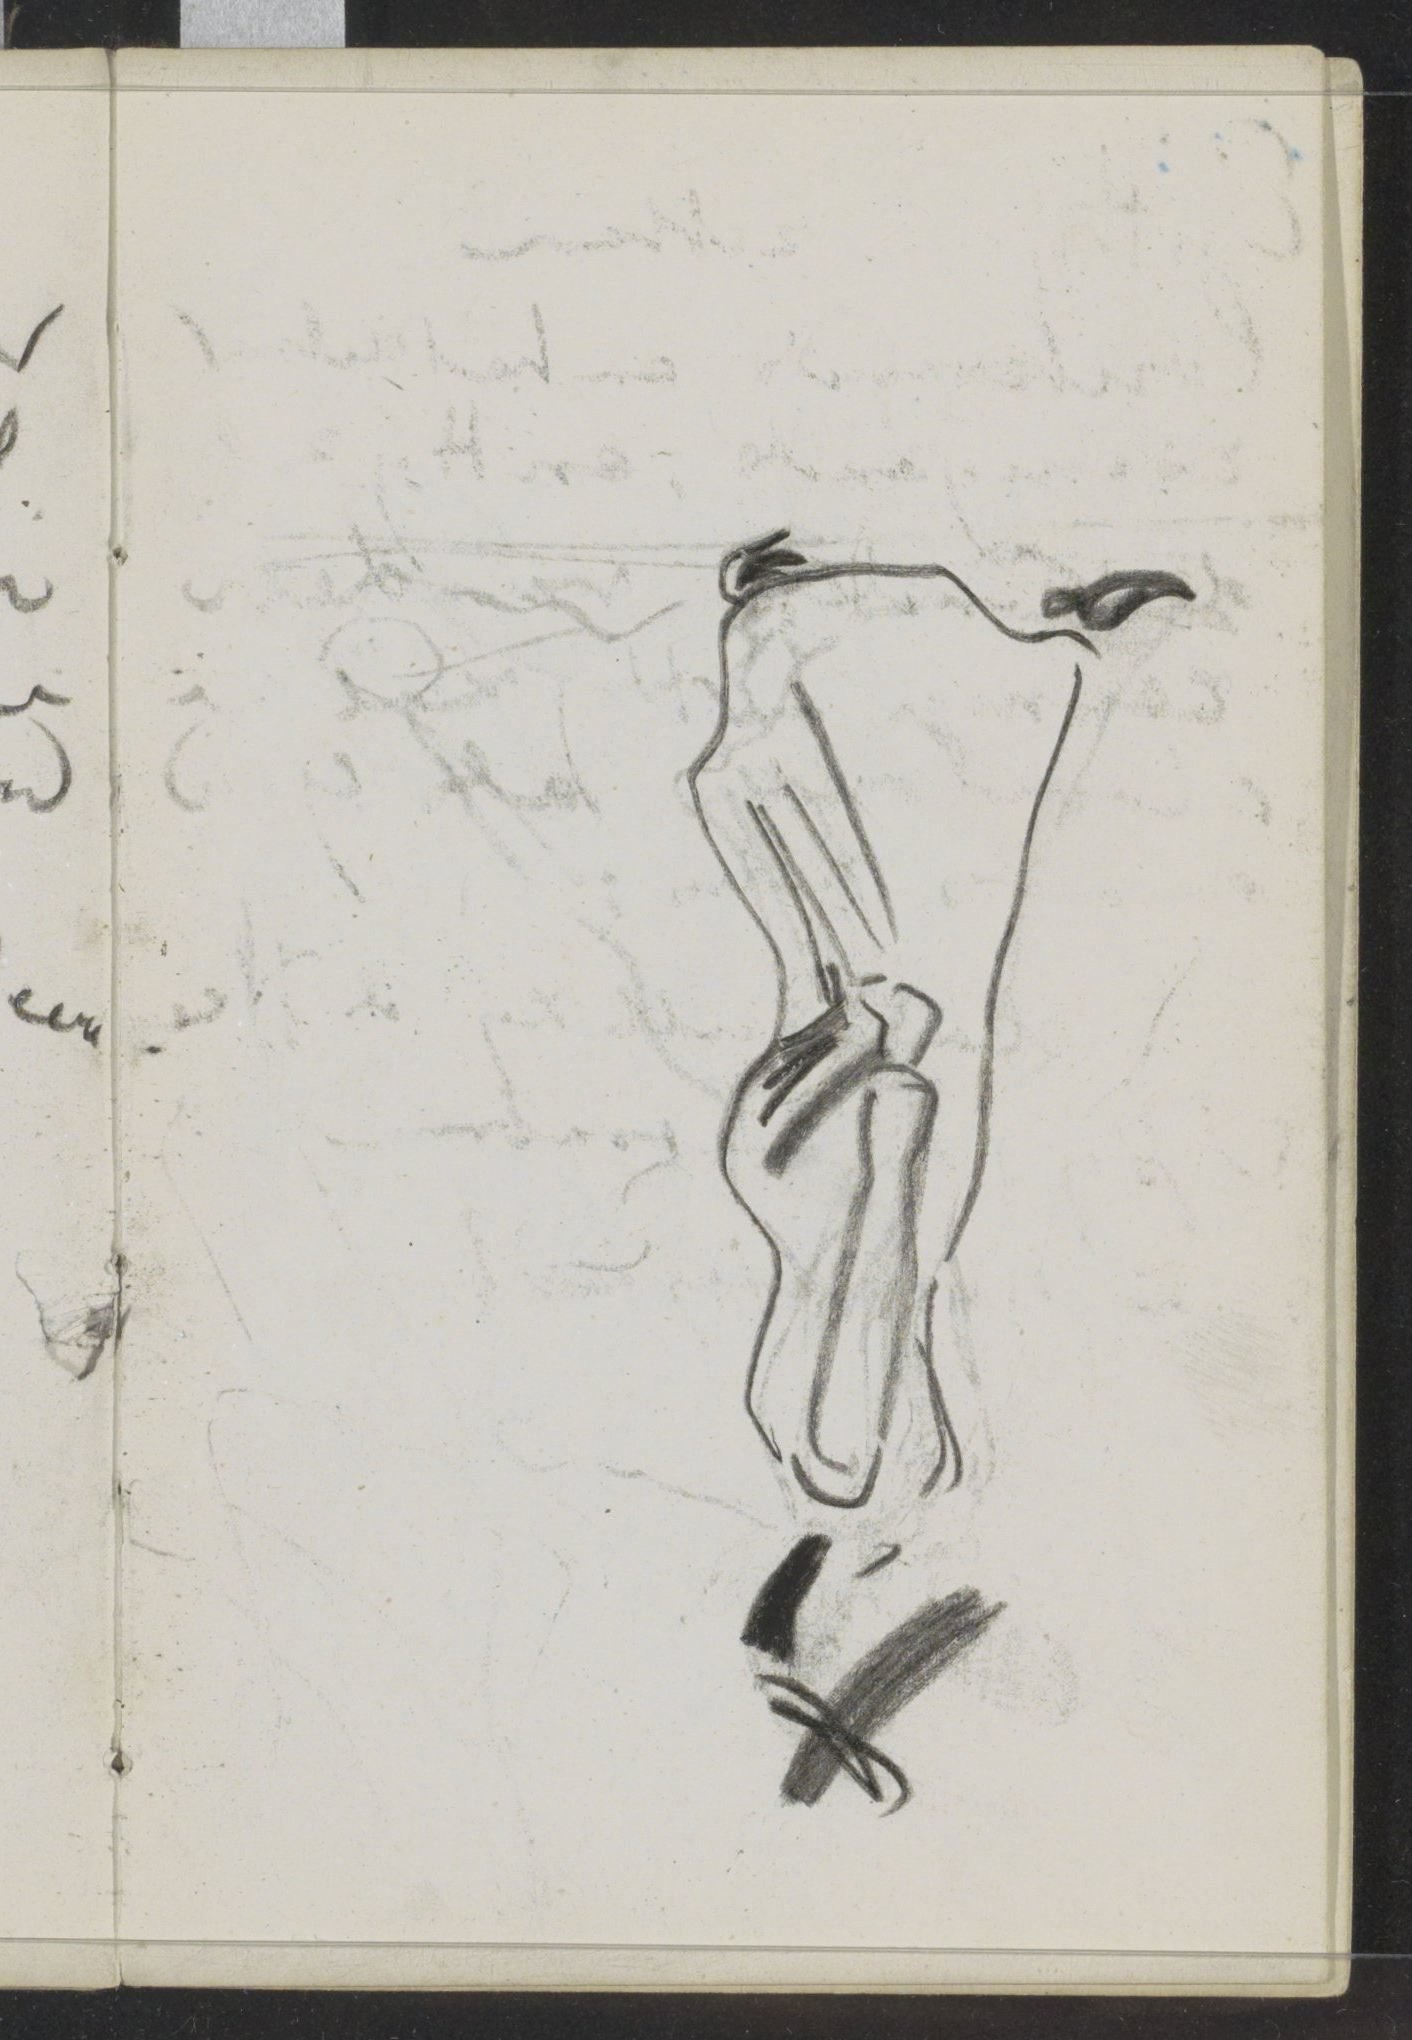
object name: sketchbook leaf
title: Lopende vrouw met een hoed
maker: carel adolph lion cachet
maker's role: draughtsman, print maker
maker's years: 1864-1945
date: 1874-1945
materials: chalk, paper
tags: walking (+ female (human being) (not to be used where -aa- is prescribed)), head-gear: hat (+ women's clothes)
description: Blad 31 recto uit een schetsboek met 41 bladen.